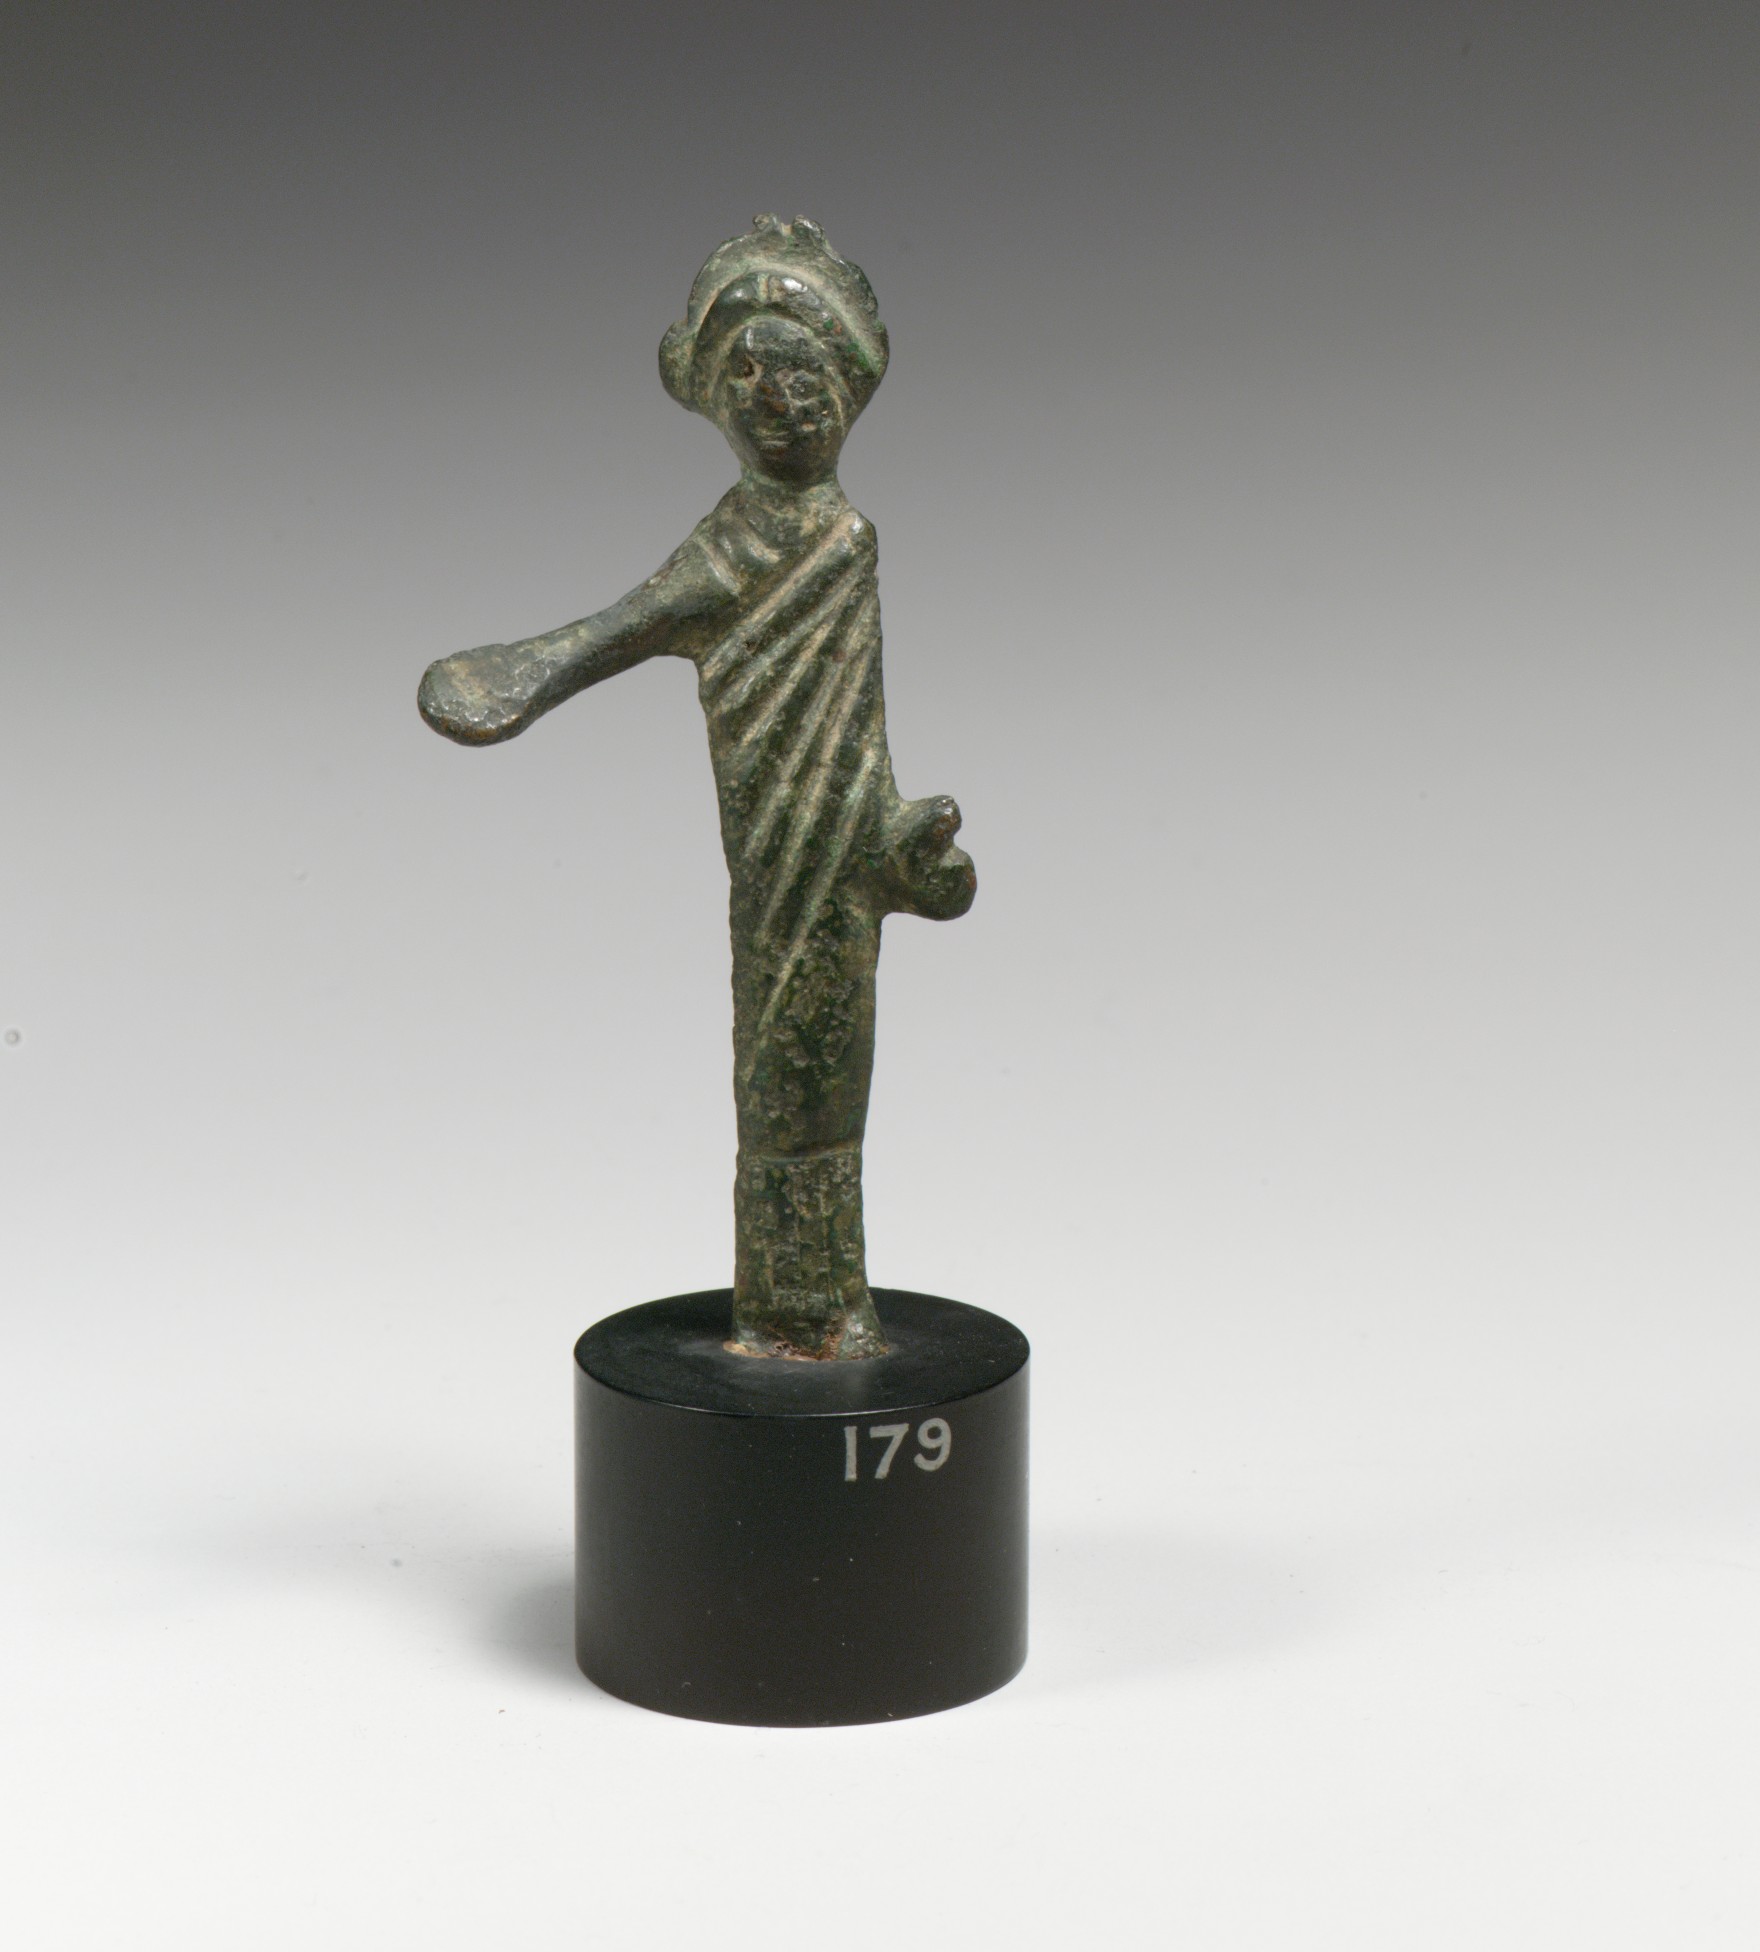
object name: statuette of a woman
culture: etruscan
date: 300-1 BCE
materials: bronze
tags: women